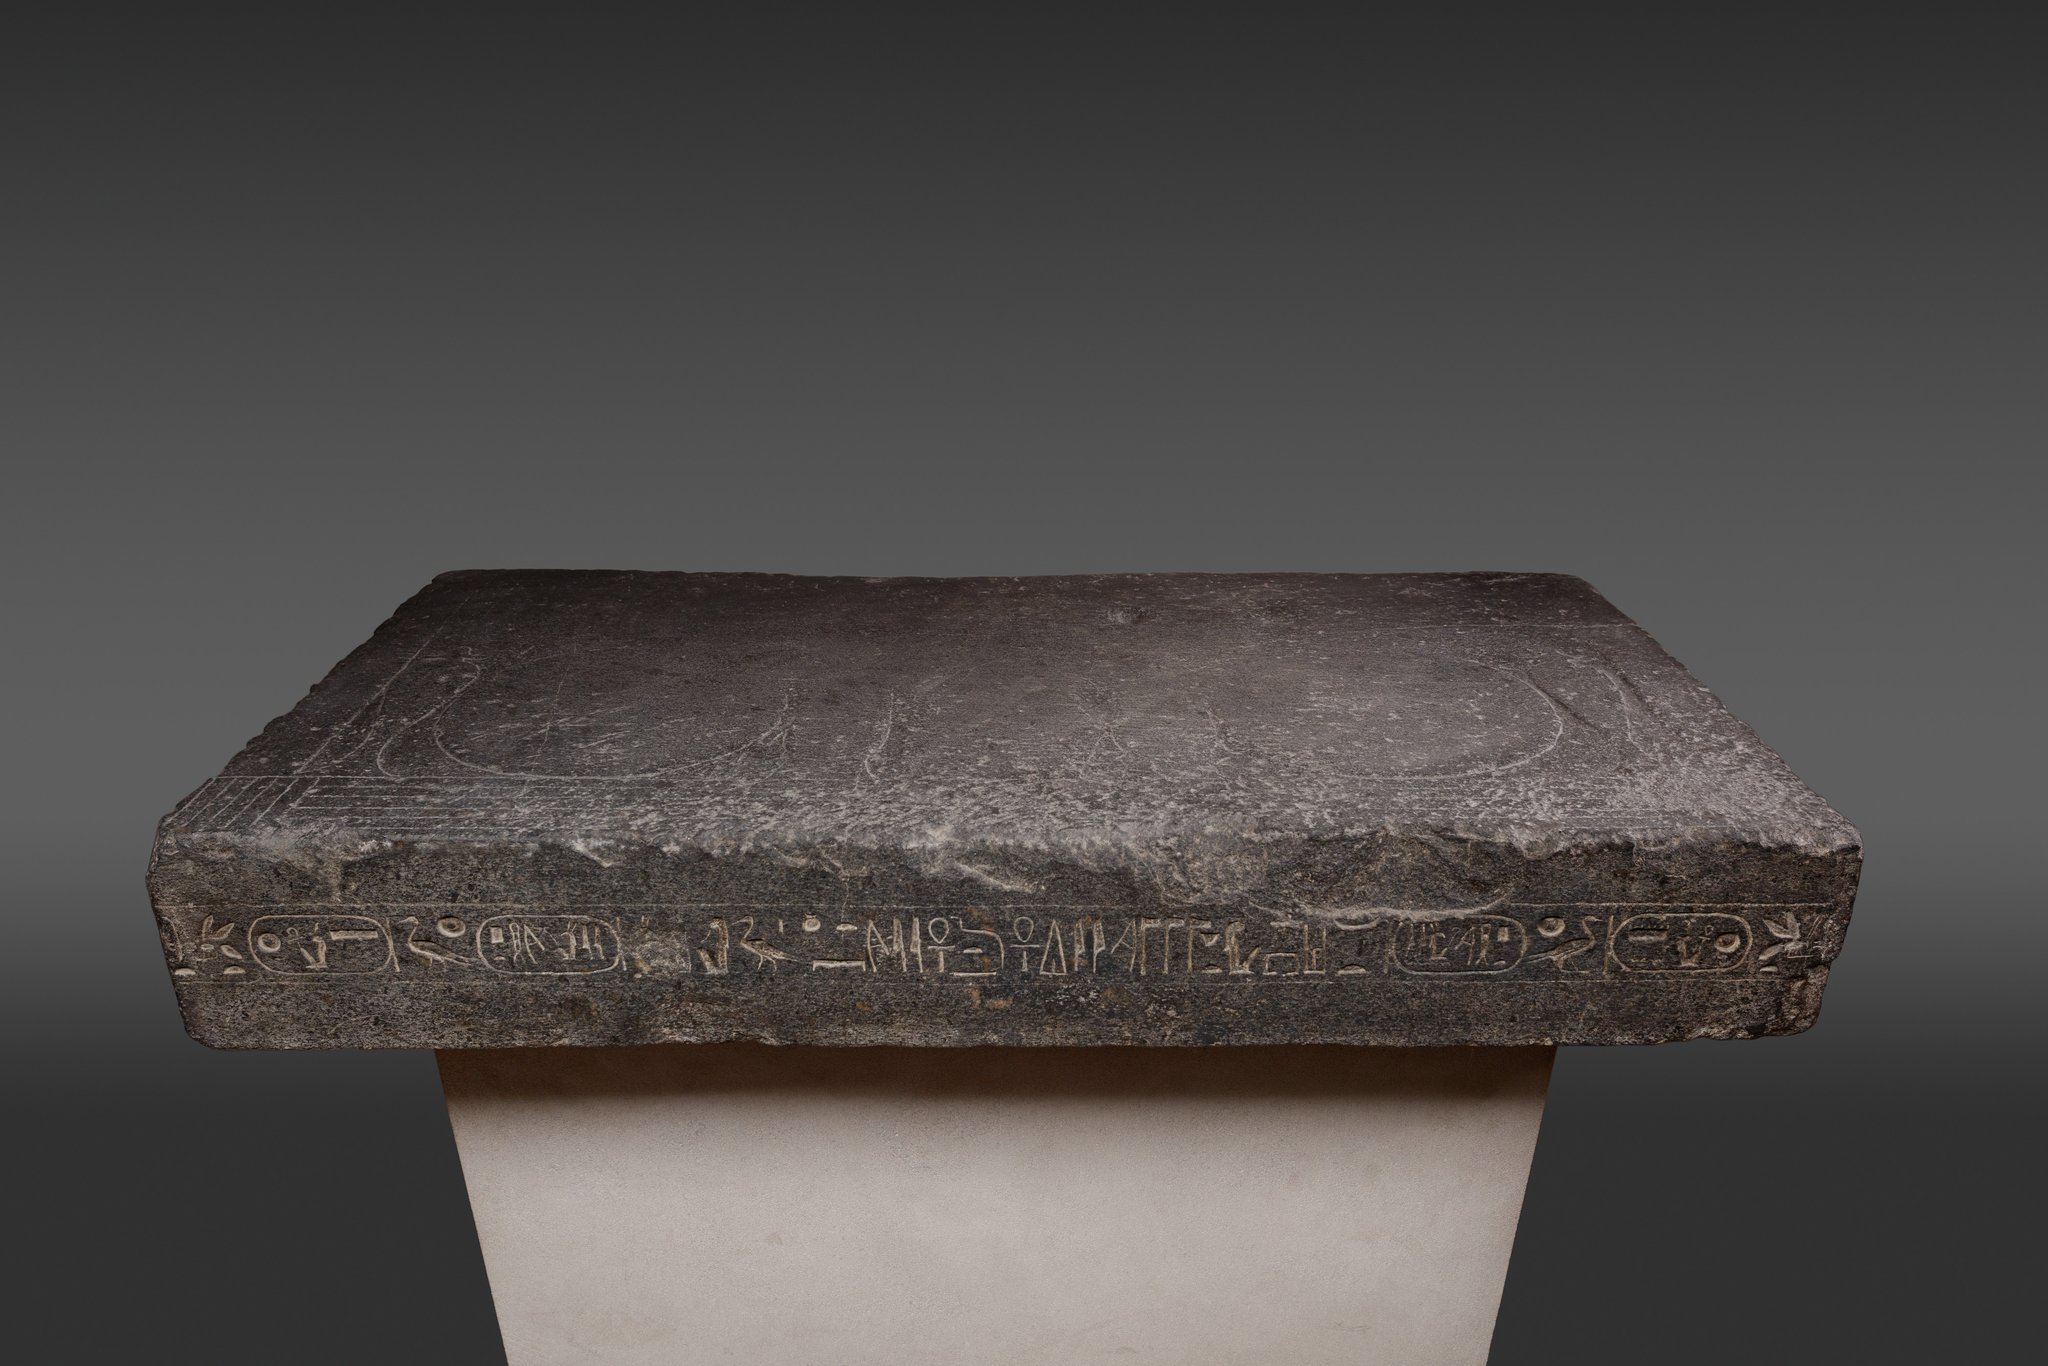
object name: offering table, seti i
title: Offering Table of Seti I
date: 1294-1279 BCE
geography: memphite region